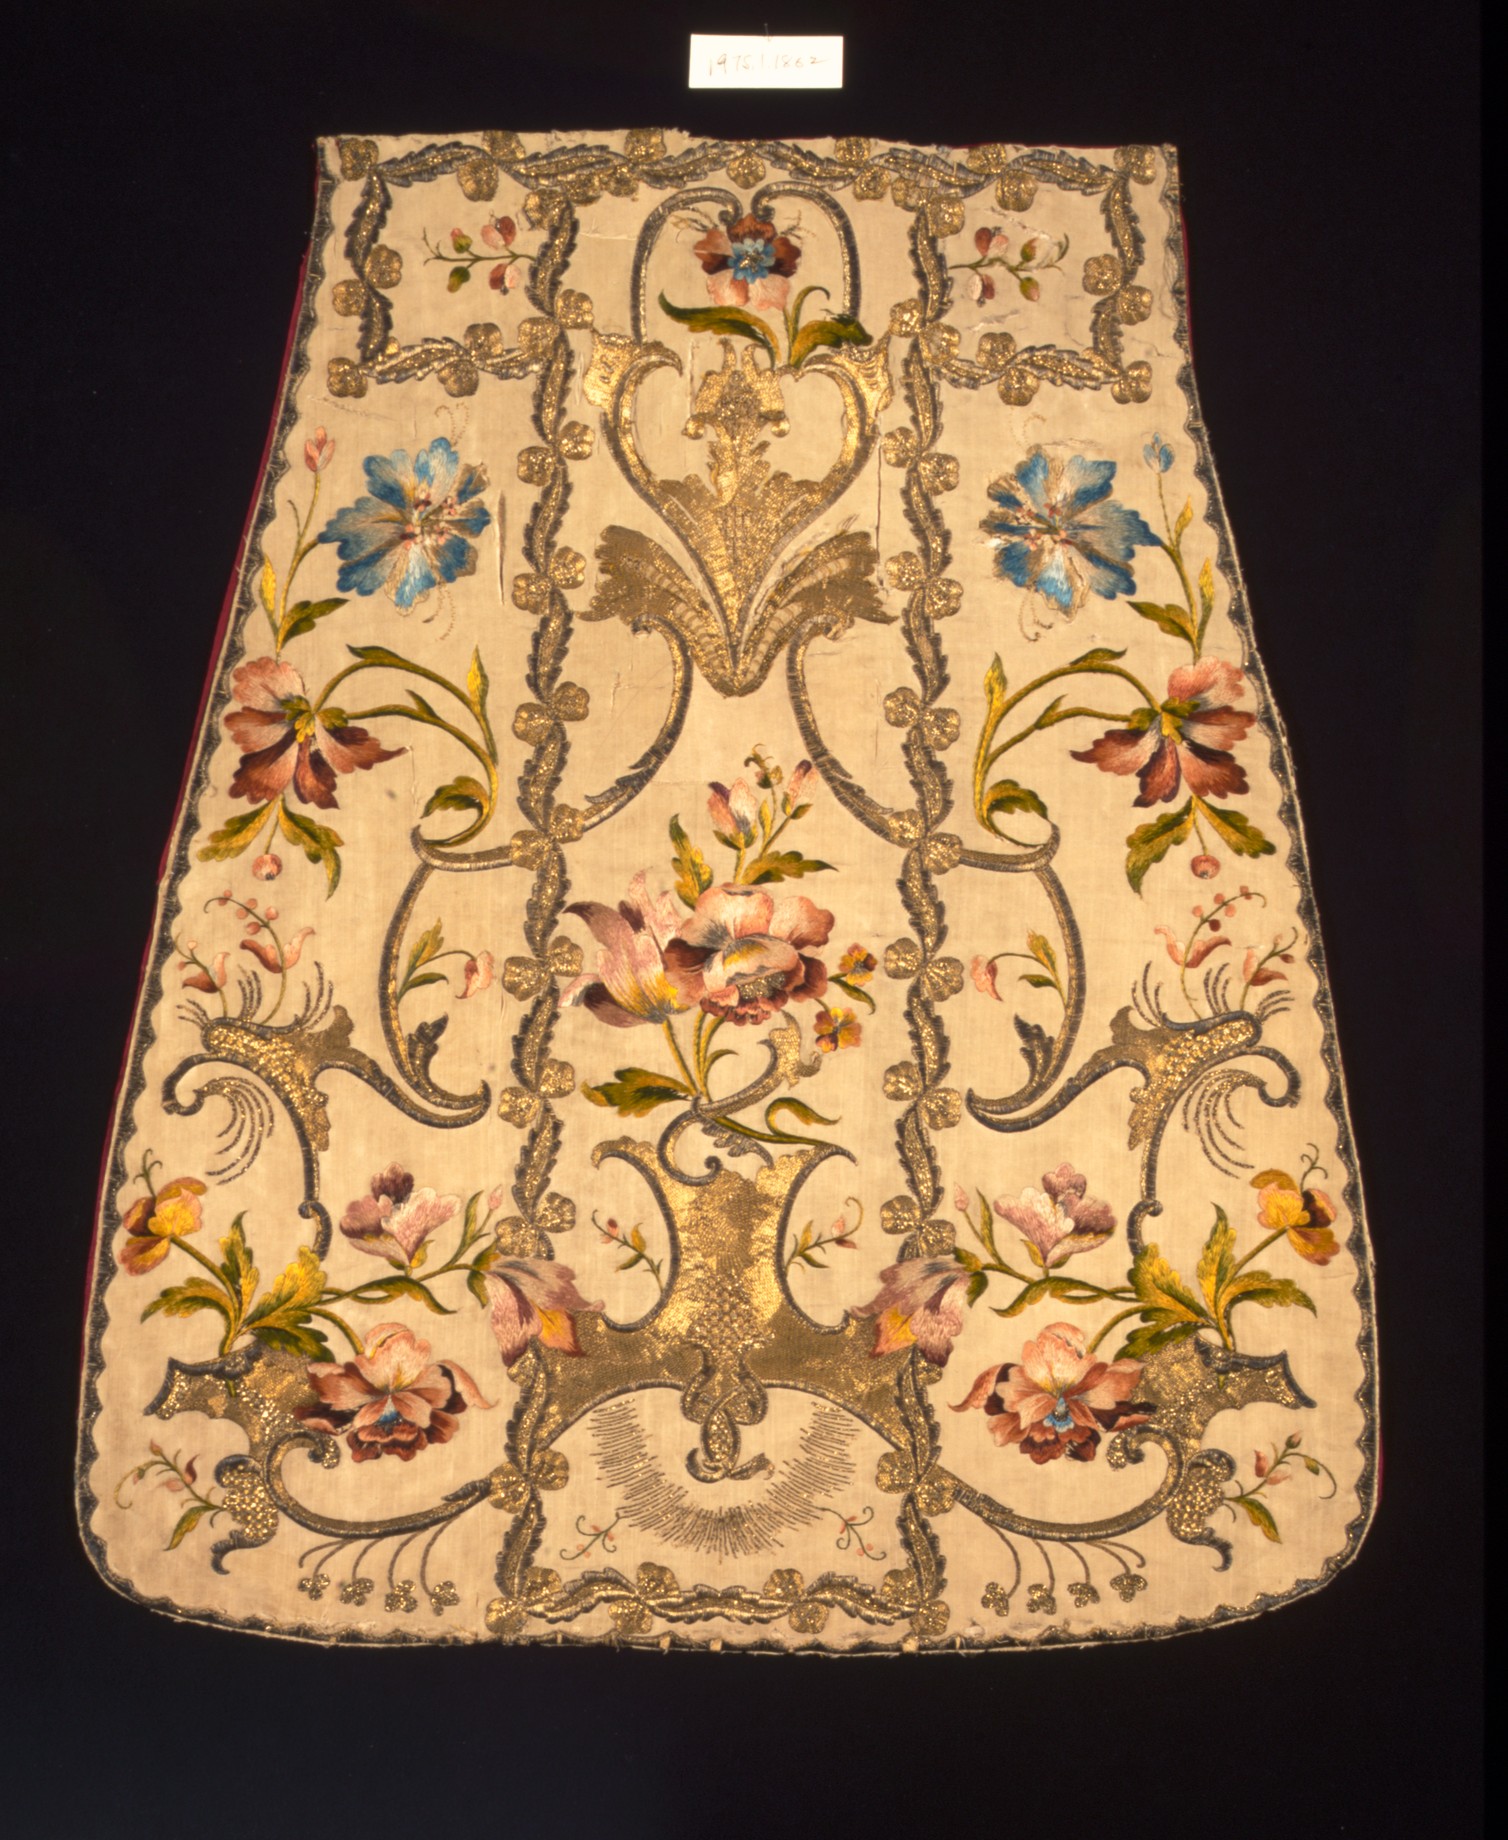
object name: chasuble front fragment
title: Part of a Chasuble Front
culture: italian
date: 1701-1800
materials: linen, metal, silk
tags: flowers